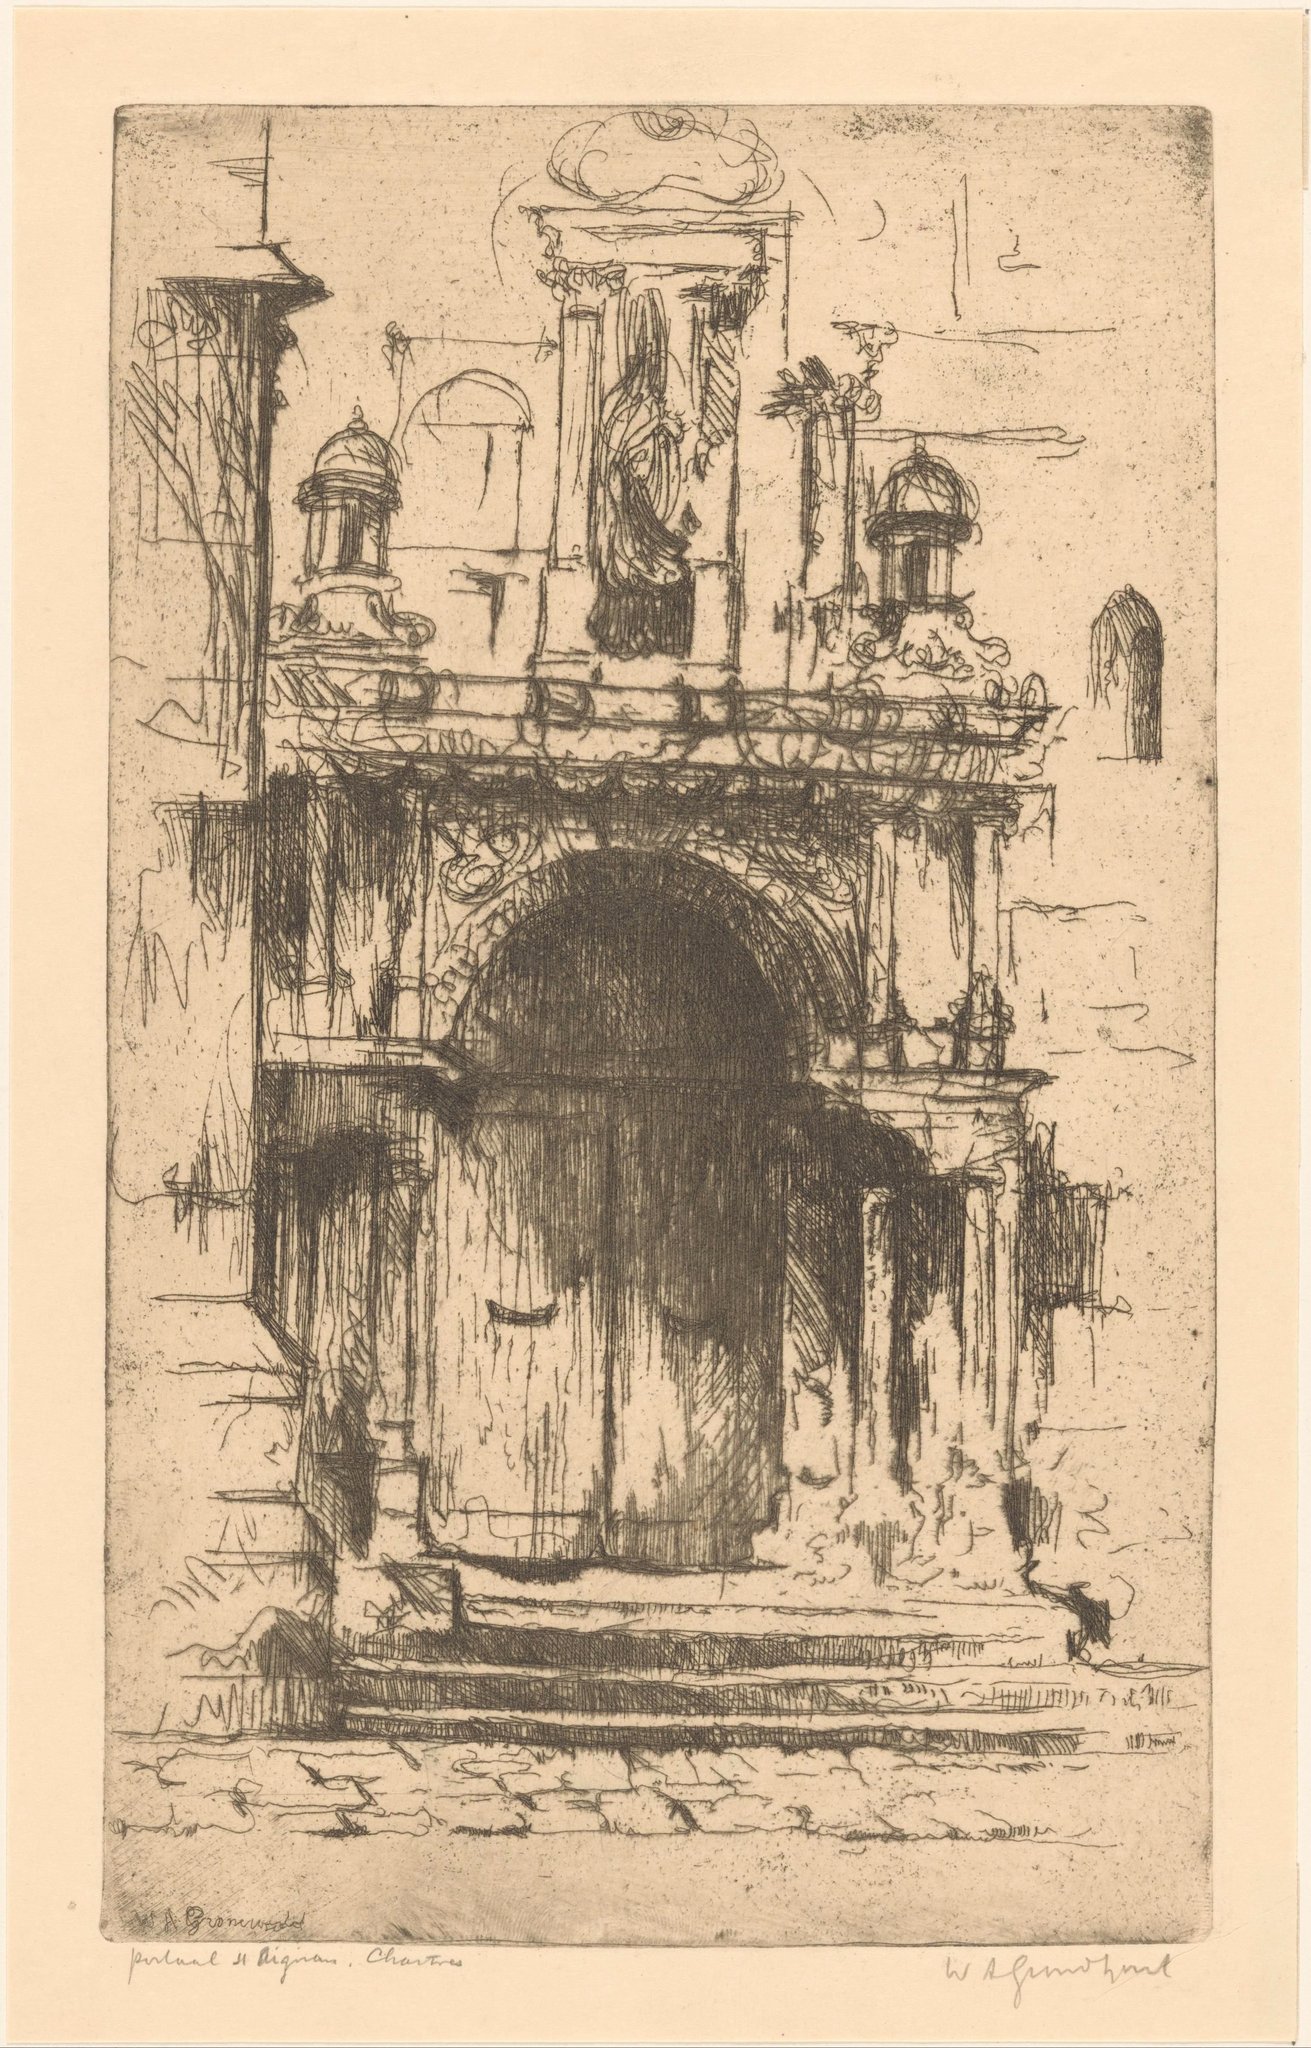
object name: print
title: Église Saint-Aignan in Chartres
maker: willem adrianus grondhout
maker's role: draughtsman, painter, print maker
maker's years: 1878-1934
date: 1888-1931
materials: paper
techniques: etching, intaglio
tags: parts of church exterior and annexes: portal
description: Een portaal in de voorgevel van de Église Saint-Aignan in Chartres.